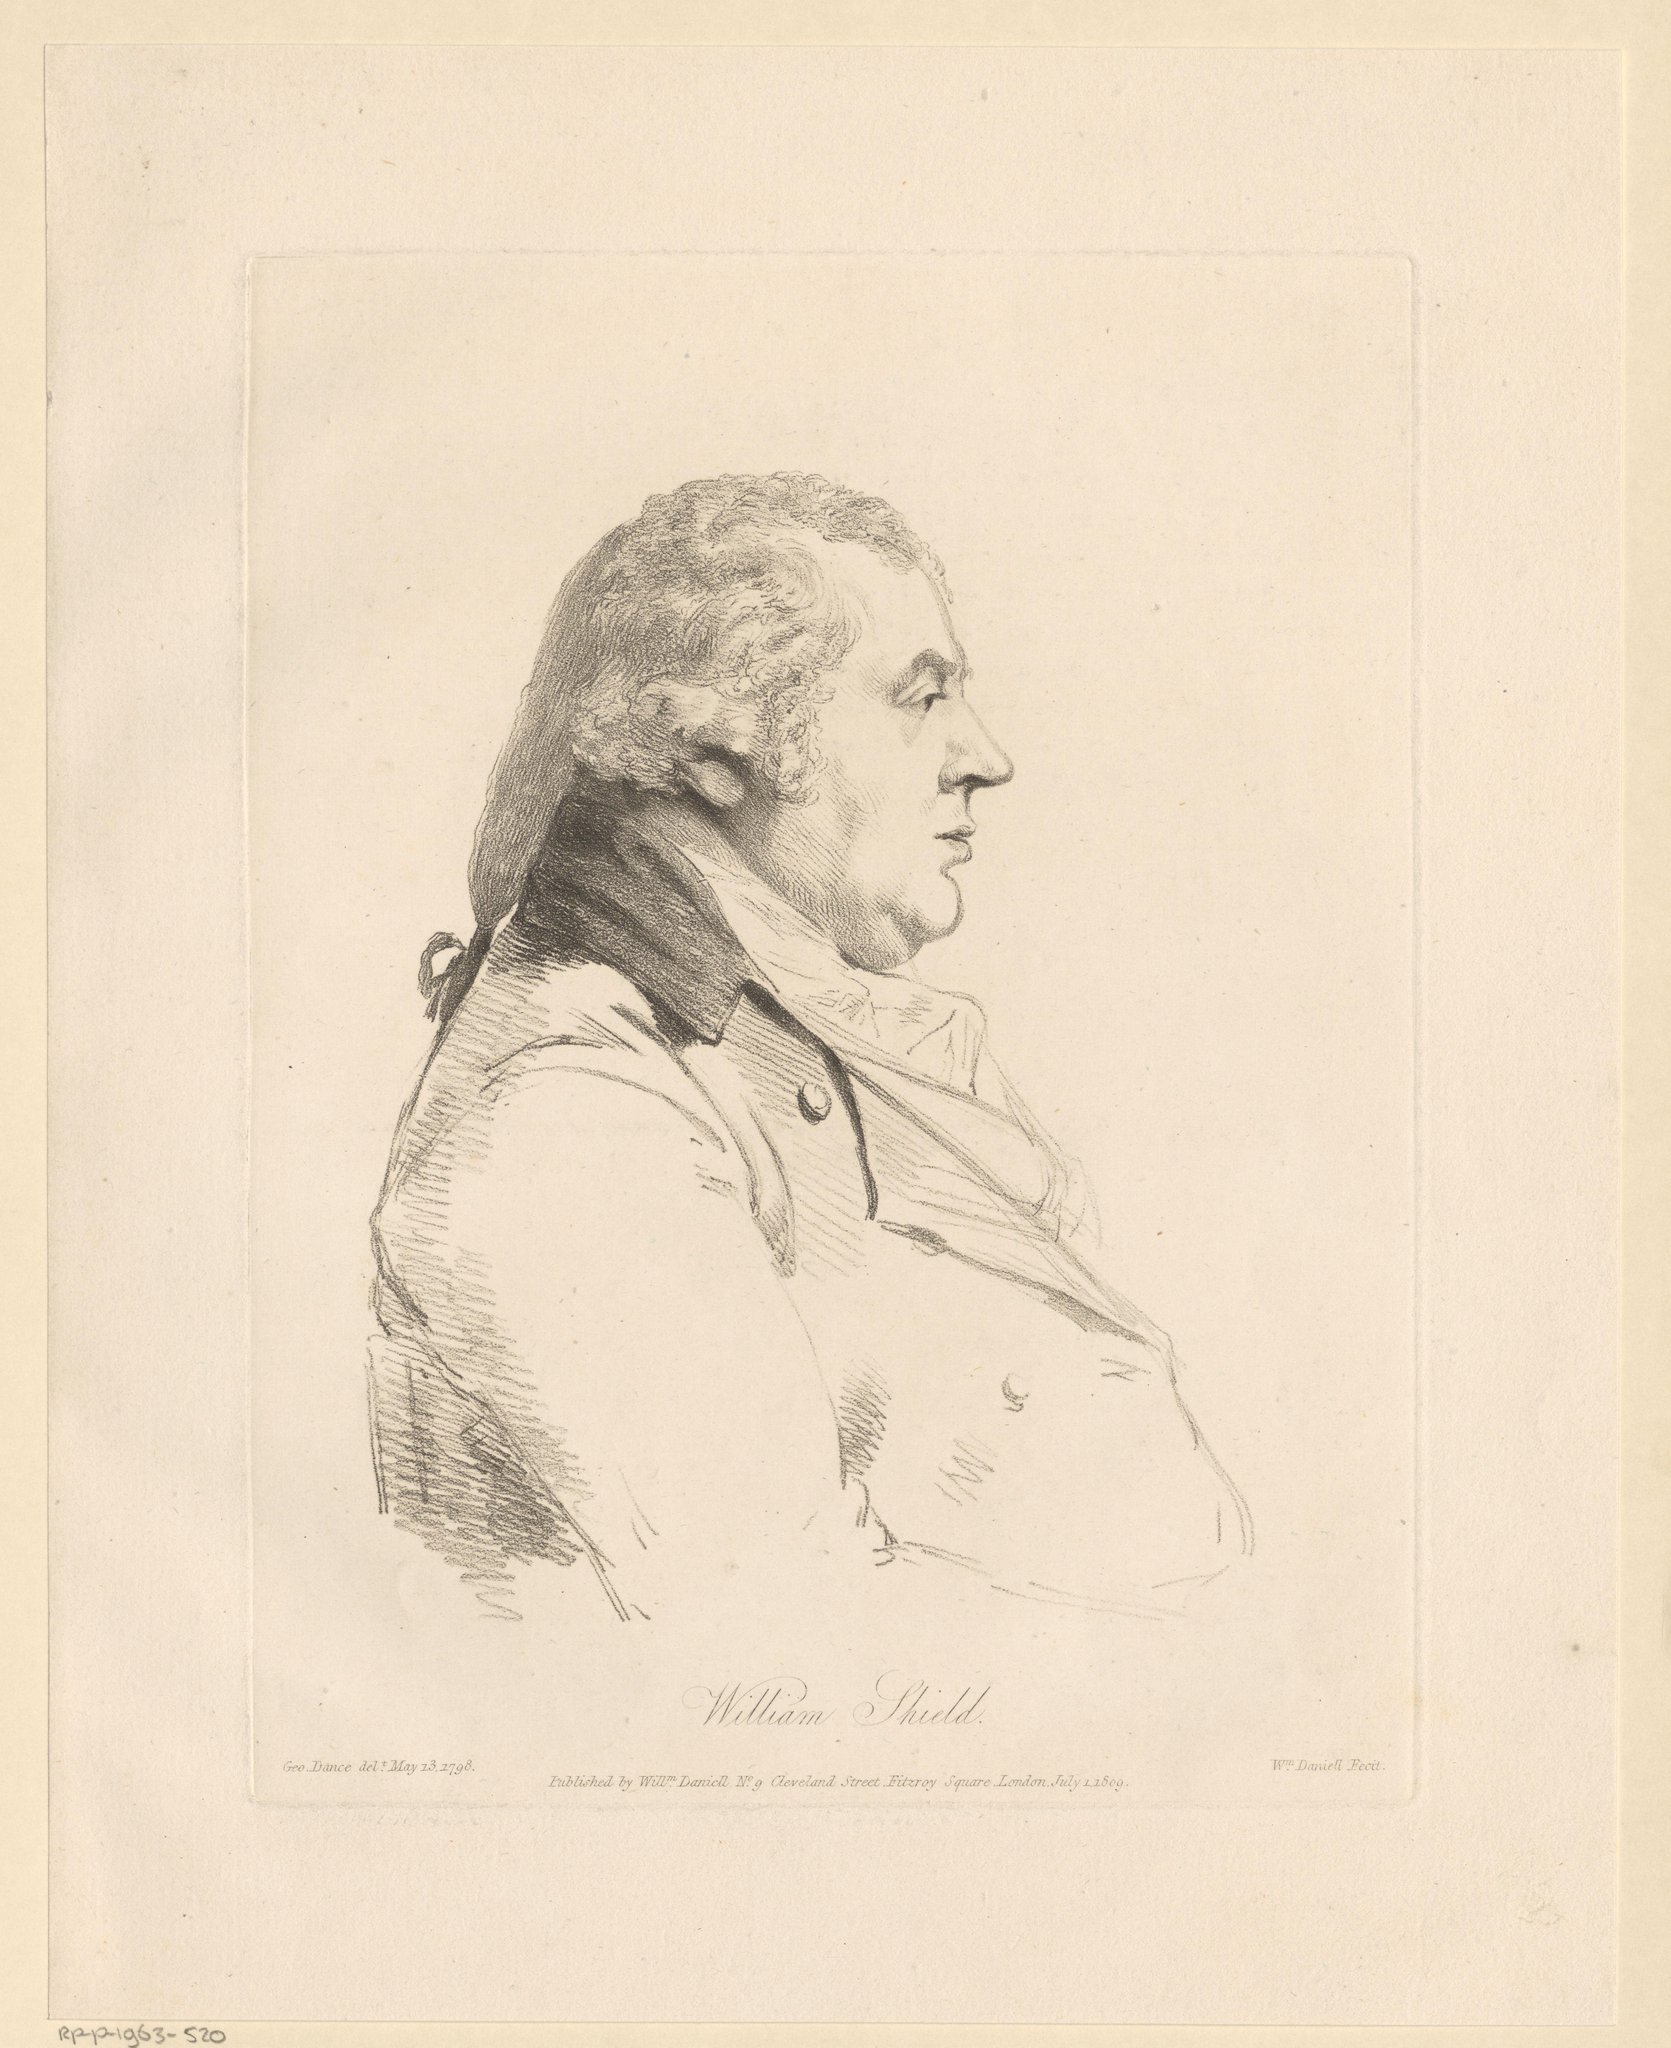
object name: print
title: Portret van William Shield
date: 1809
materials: paper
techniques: etching, lithograph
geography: london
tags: historical persons, portrait of composer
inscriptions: collector's mark: Lugt 2228